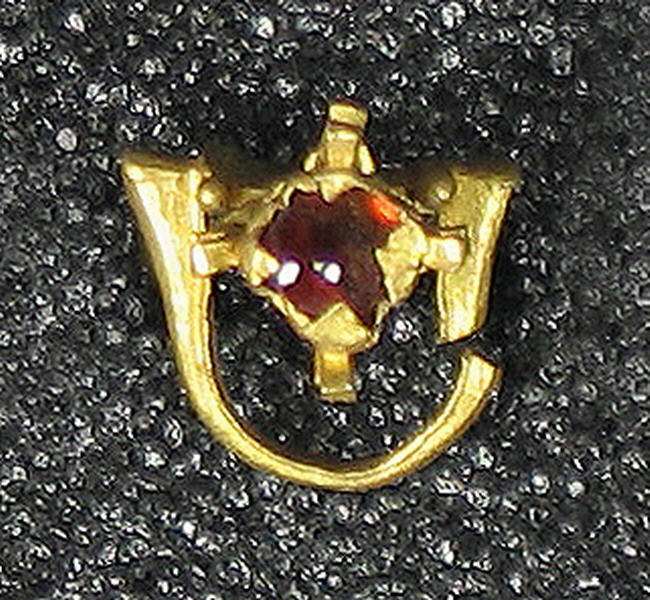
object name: earring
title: Cast Earring with Ruby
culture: indonesian, central java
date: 701-1200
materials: gold